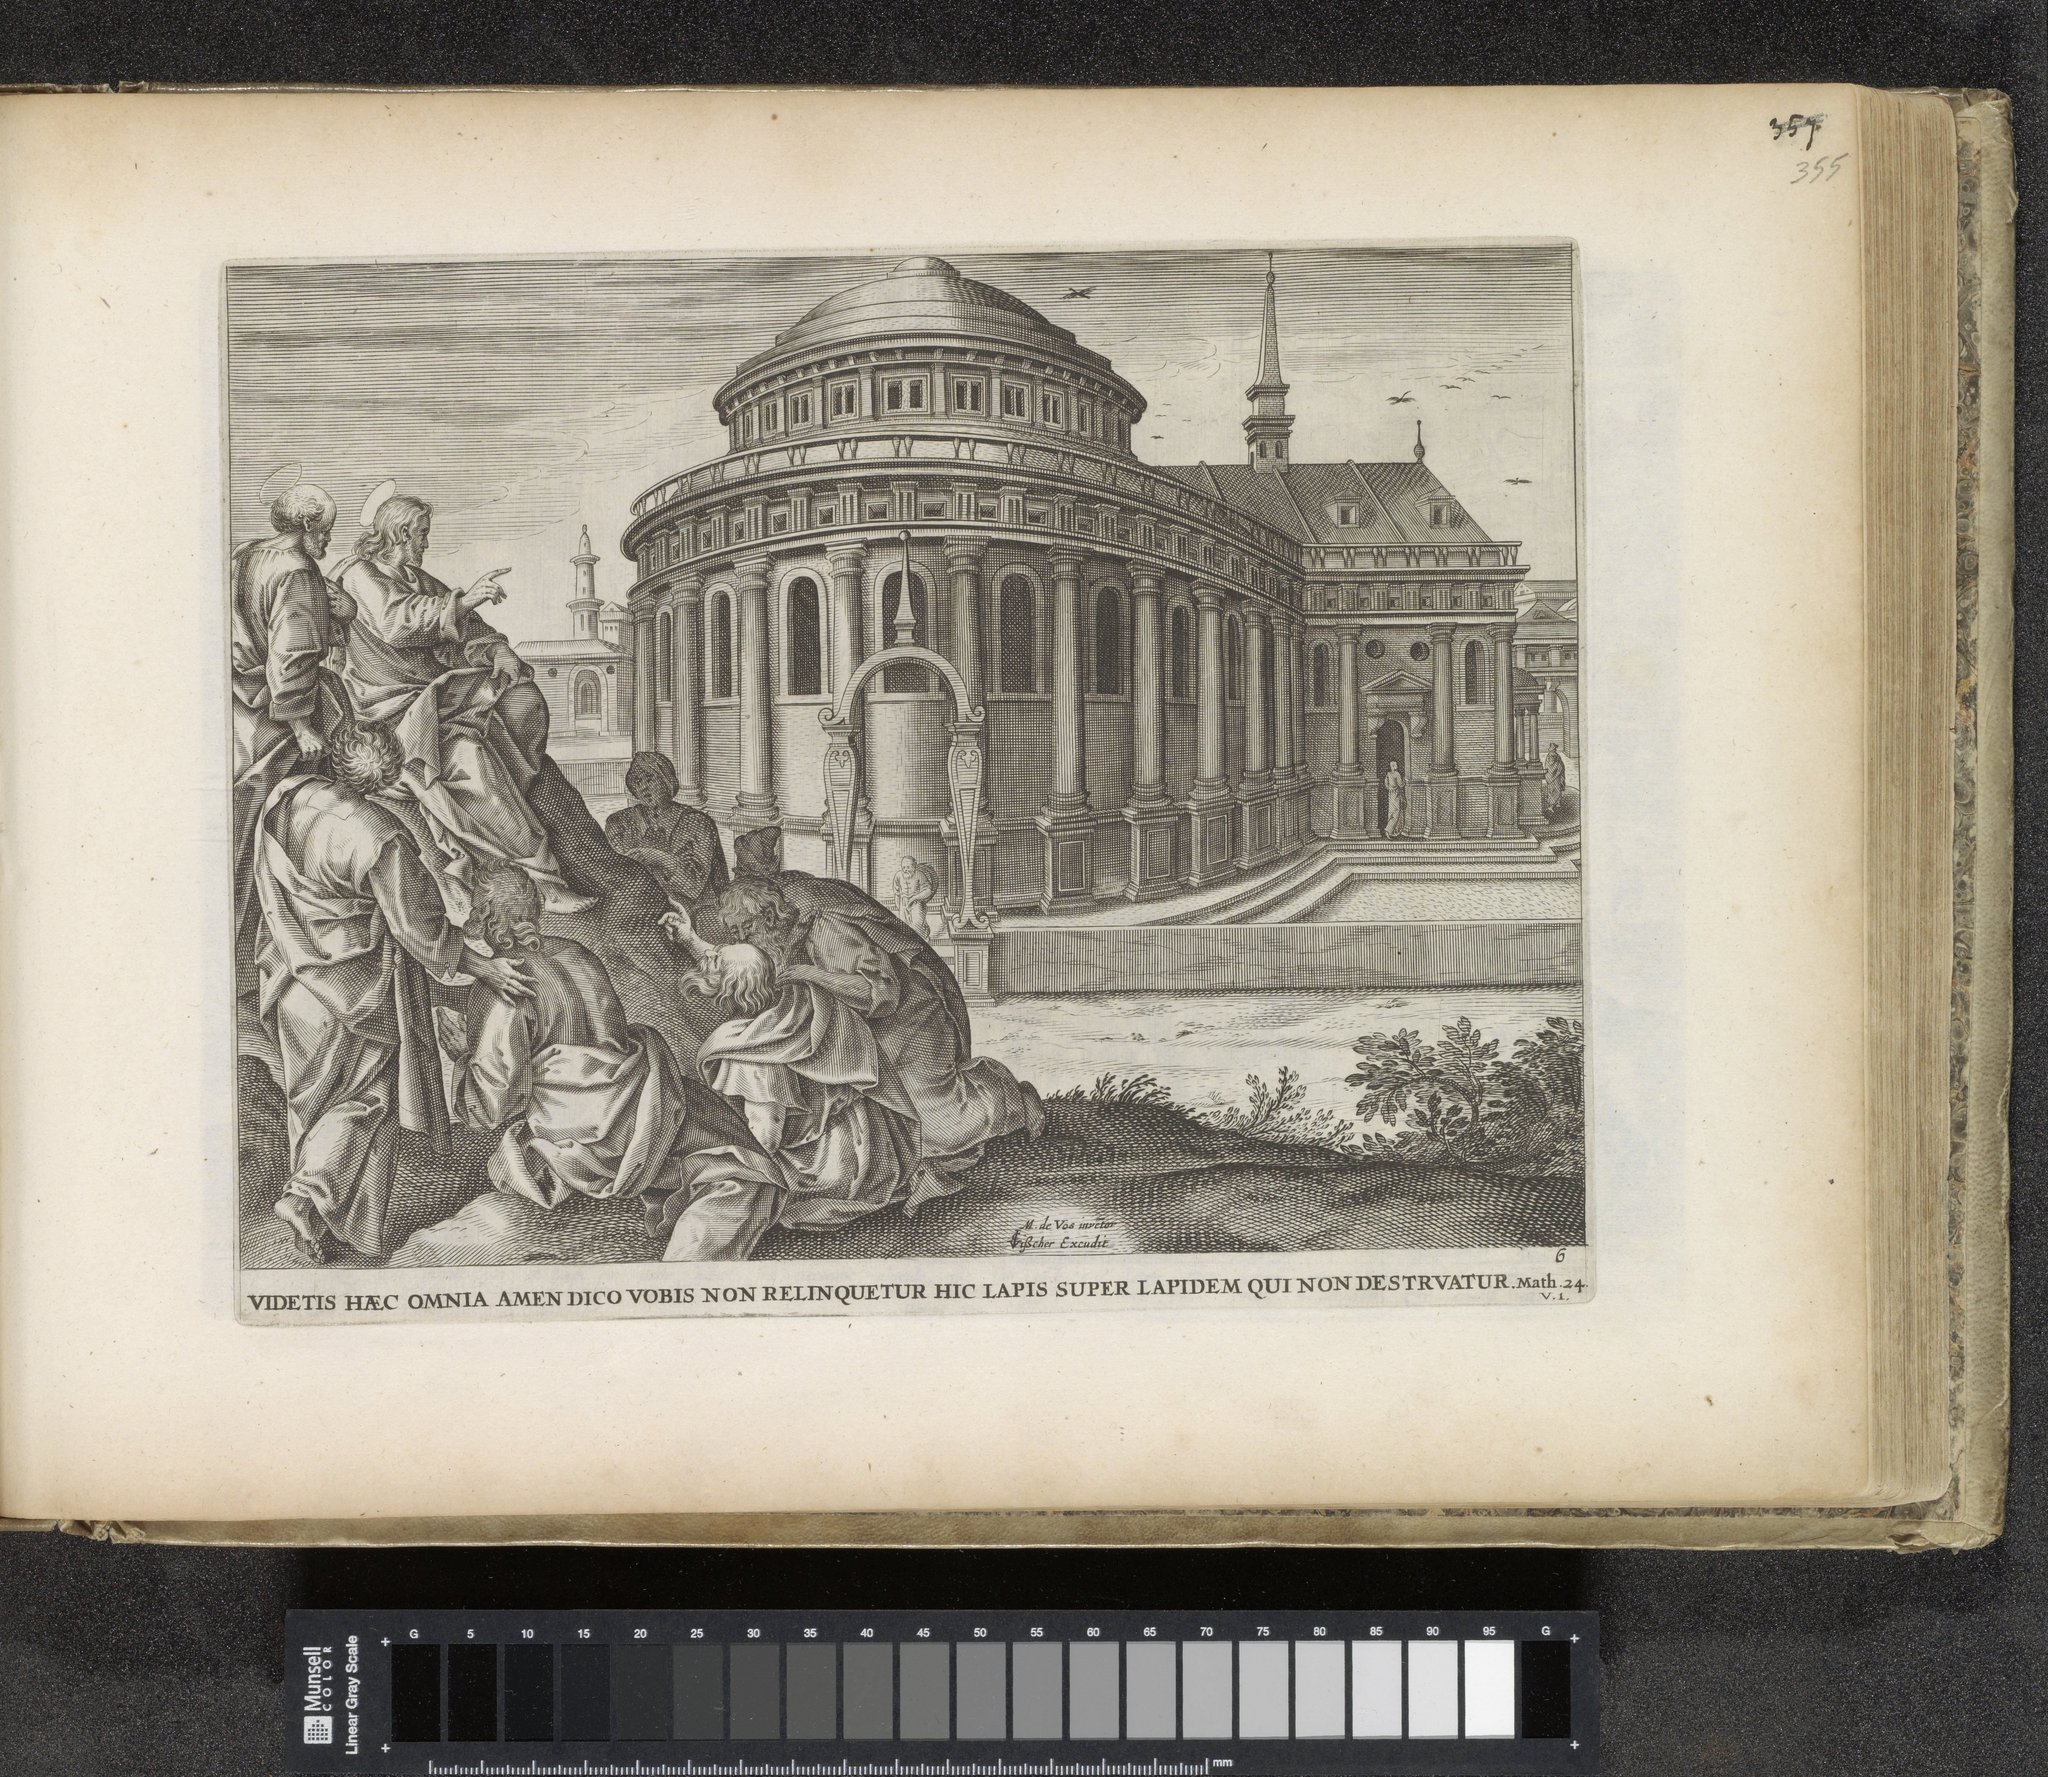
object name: print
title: Christus voorspelt de verwoesting van de tempel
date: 1643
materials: paper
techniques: engraving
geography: amsterdam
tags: sayings of christ: discourse on the last things (matthew 24; mark 13; luke 21)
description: Links op de voorgrond zit Christus. Hij vertelt zijn leerlingen, terwijl hij wijst op de tempelgebouwen, dat geen steen op de andere zal blijven staan. Onder de voorstelling een verwijzing in het Latijn naar de Bijbeltekst in Mat. 24:1. Deze prent maakt deel uit van een album.